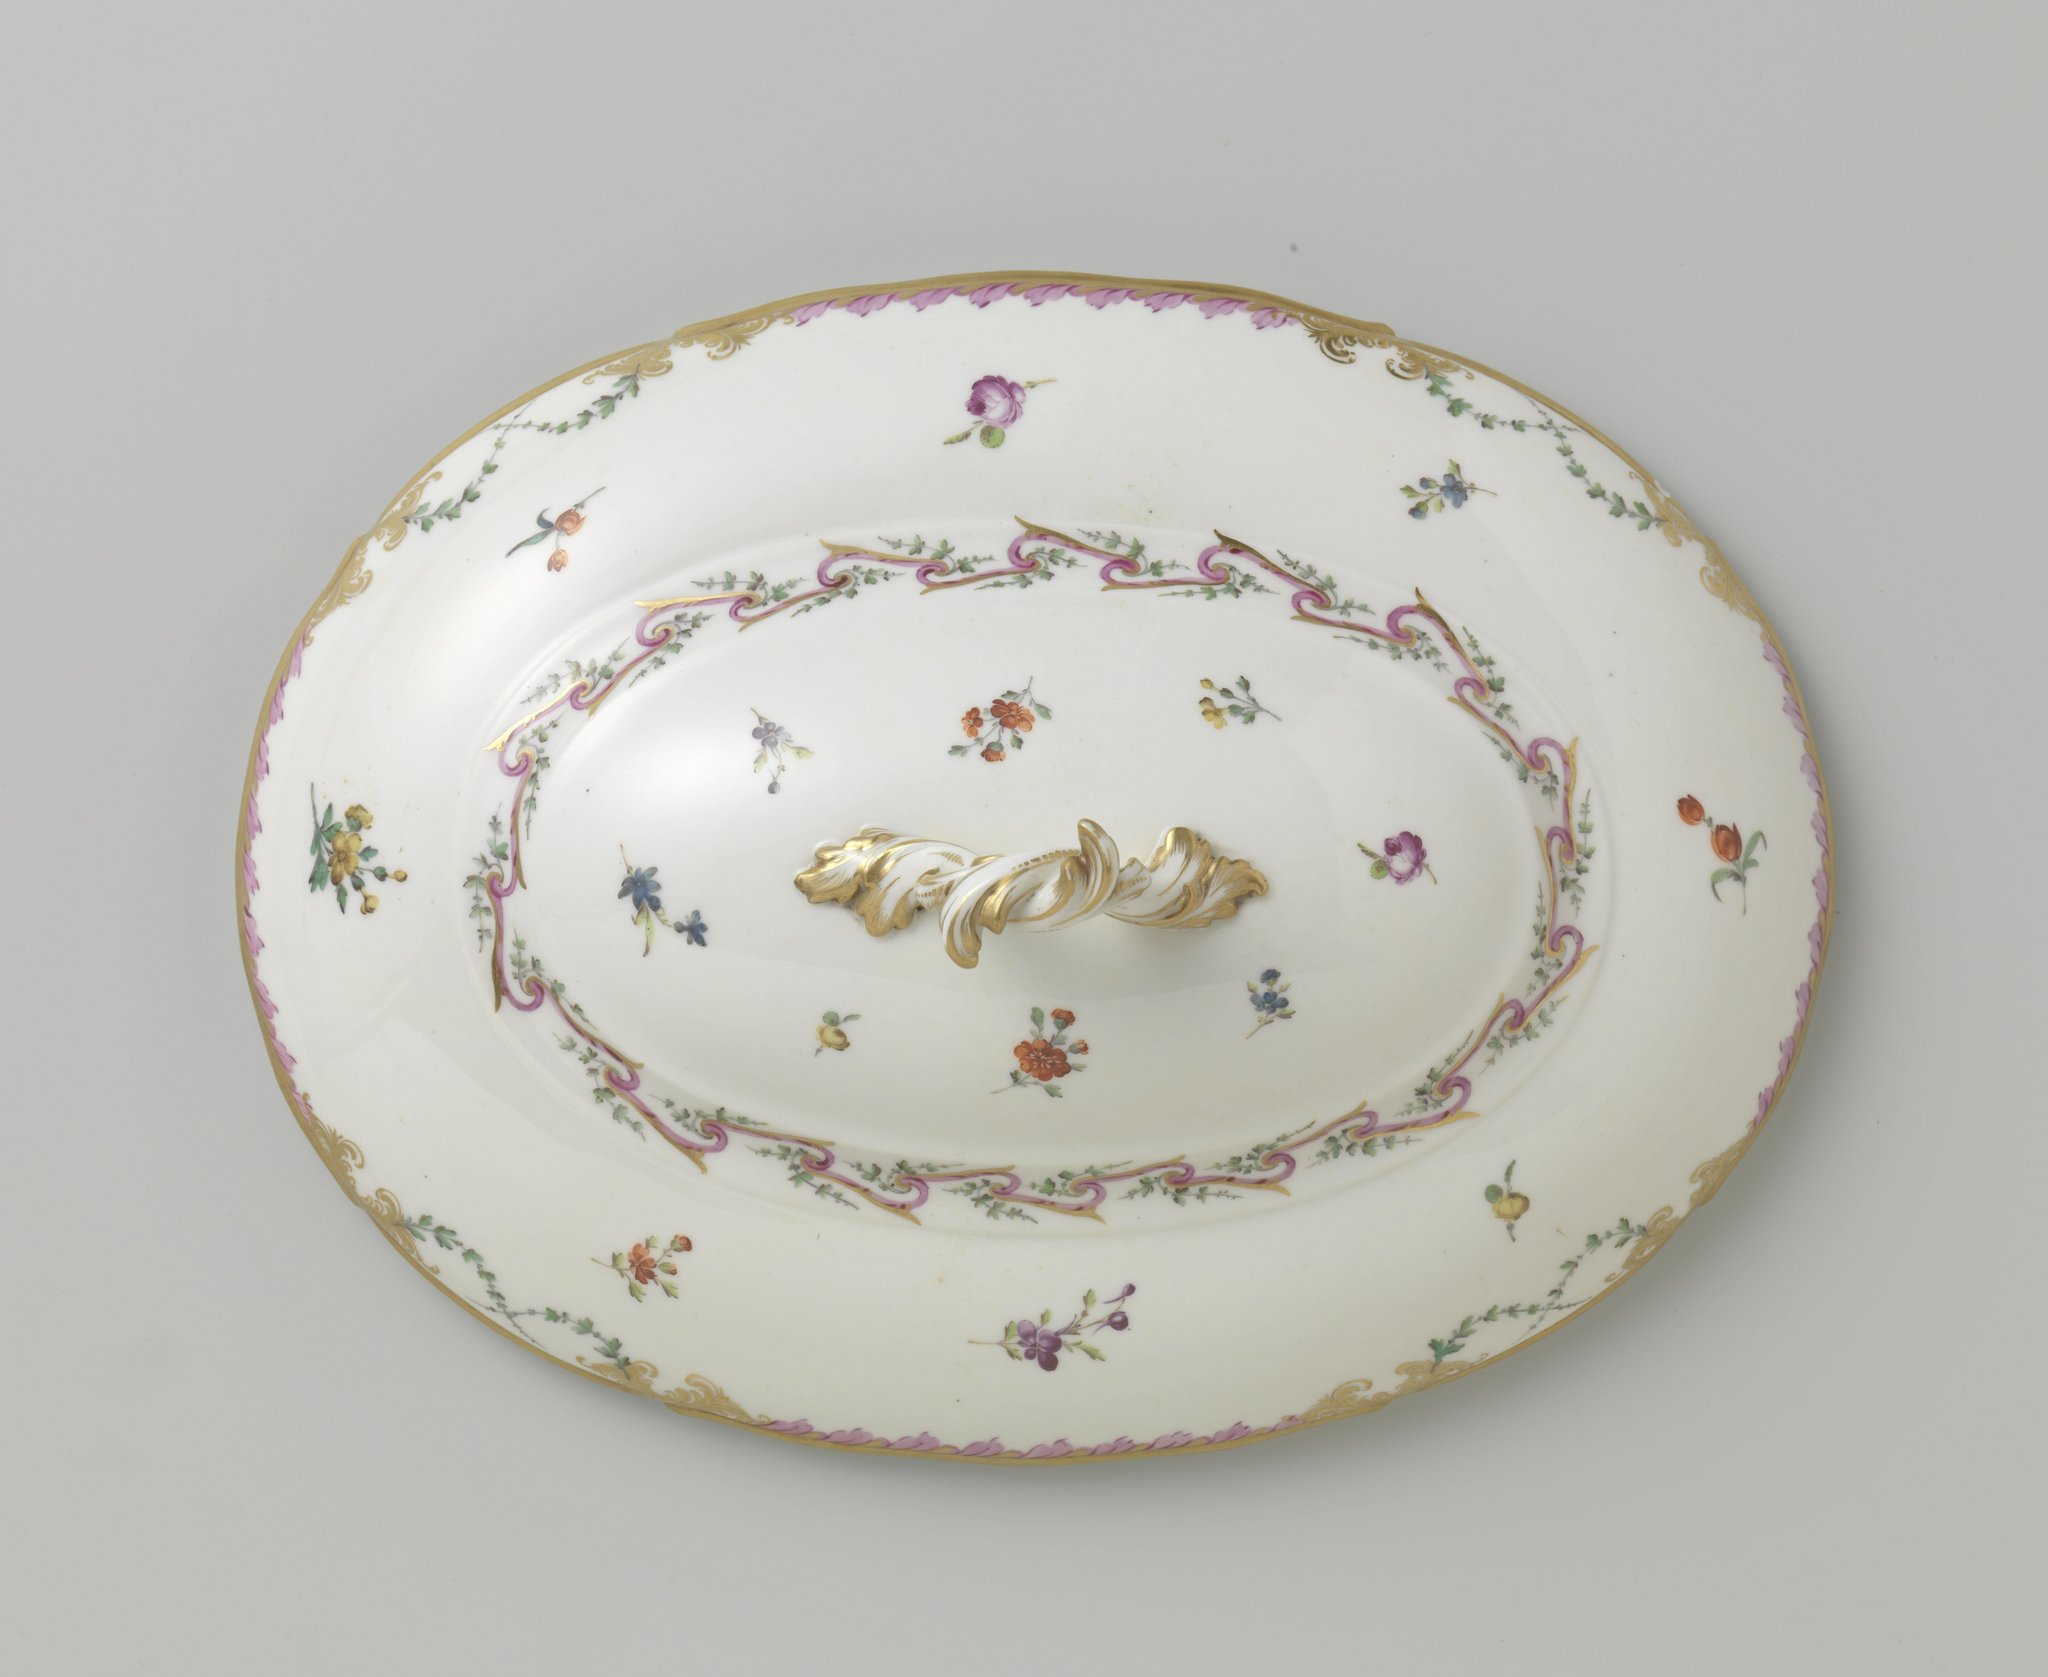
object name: lid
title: Deksel met knop, ovaal van vorm, behorend bij een servies met geslingerd lintmotief met bladertakken, bloemboeketten en gestrooide bloemtakken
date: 1780-1820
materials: porcelain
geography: loosdrecht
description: Deksel met knop, ovaal van vorm, behorend bij een servies van porselein met geslingerd motief in paars en goud met groene bladertakken, bloemboeketten en gestrooide bloemtakken. Randen lichtgegolfd met decoratie in goud met paars bladmotief waartussen groen gekruist bladmotief. Gemerkt: M.O.L. en AMSTEL.